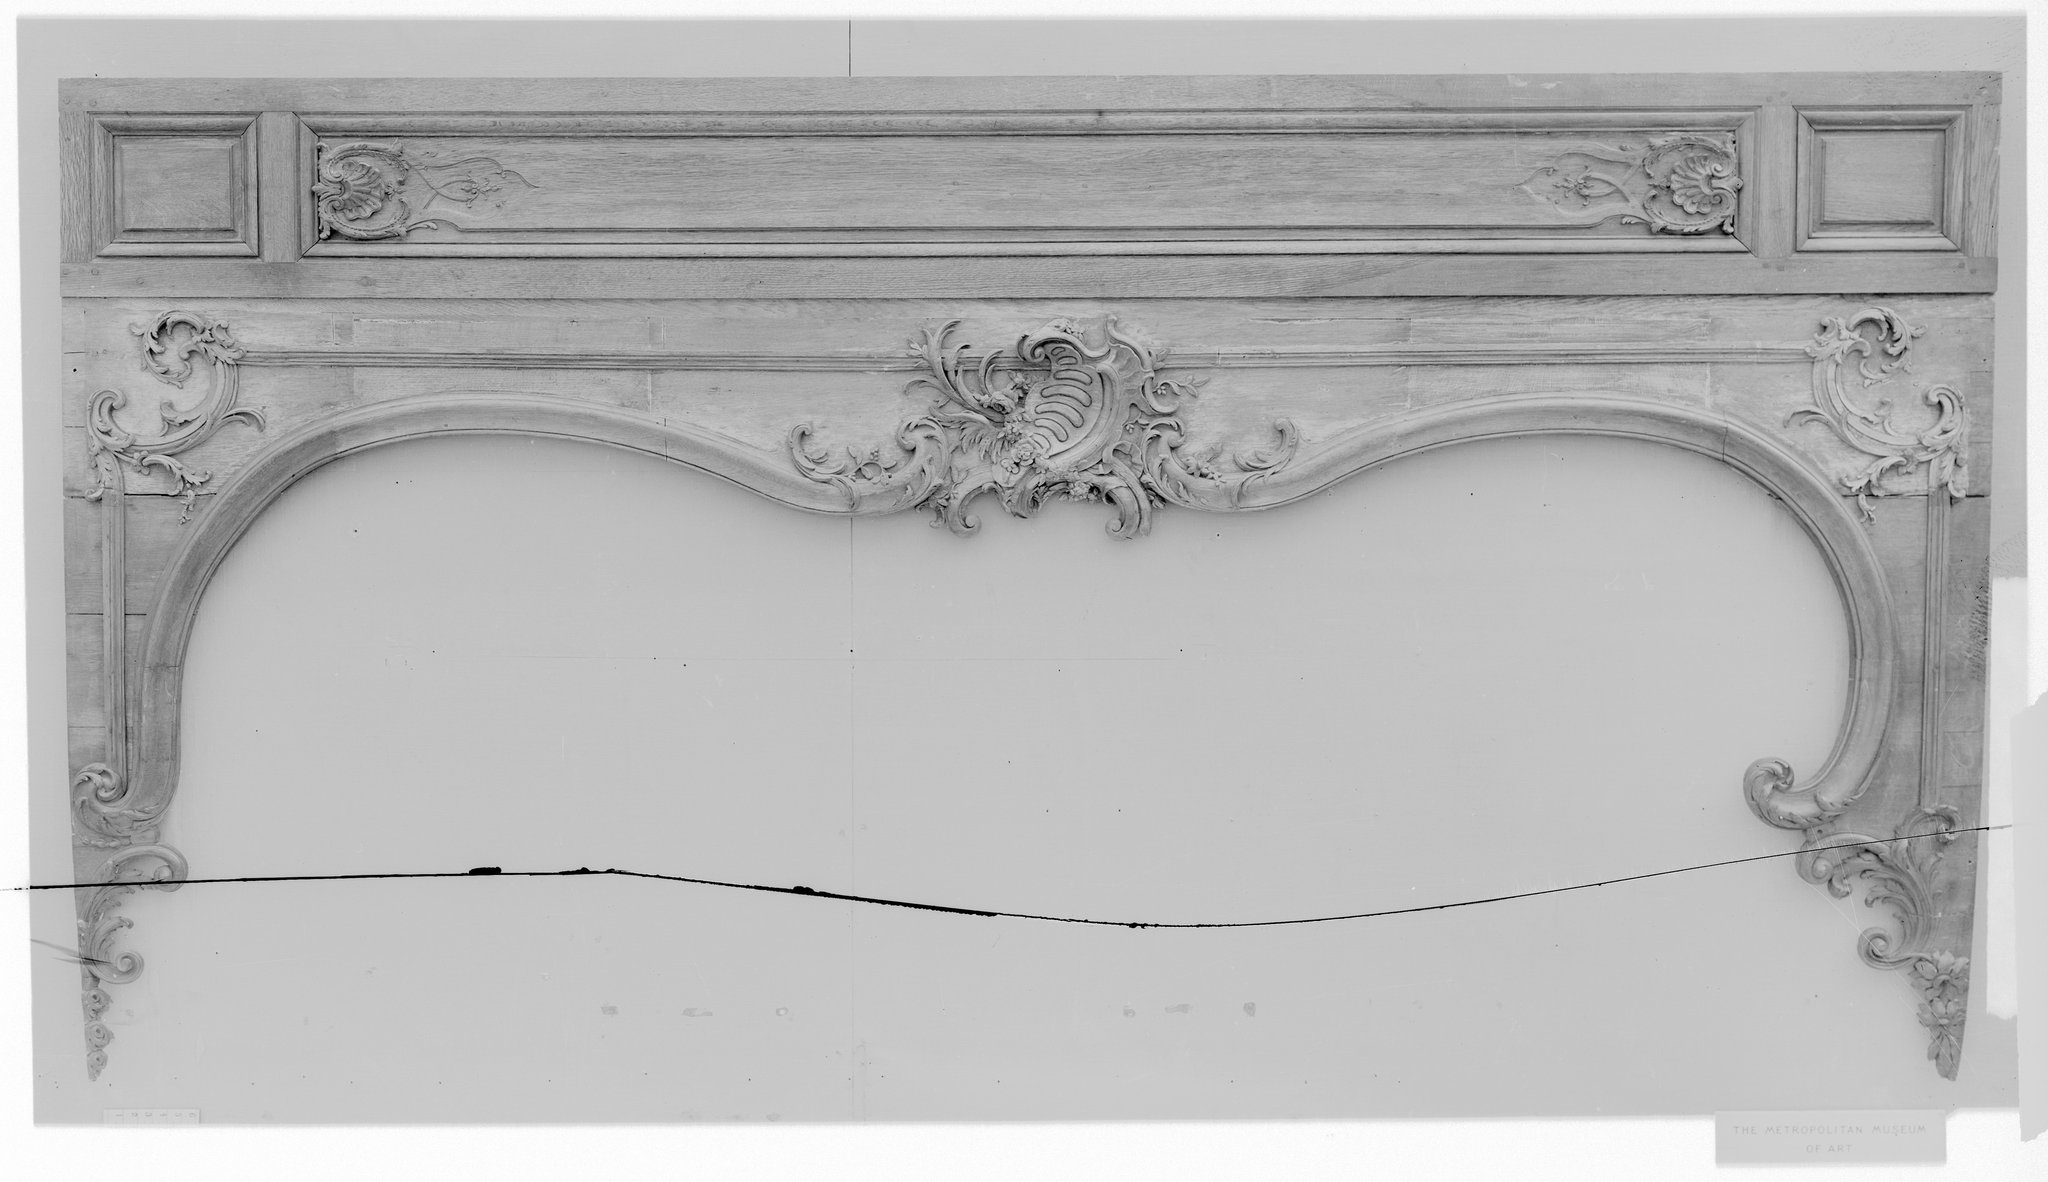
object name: panel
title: Panel (Dessus d'alcove)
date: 1701-1750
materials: wood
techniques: carving